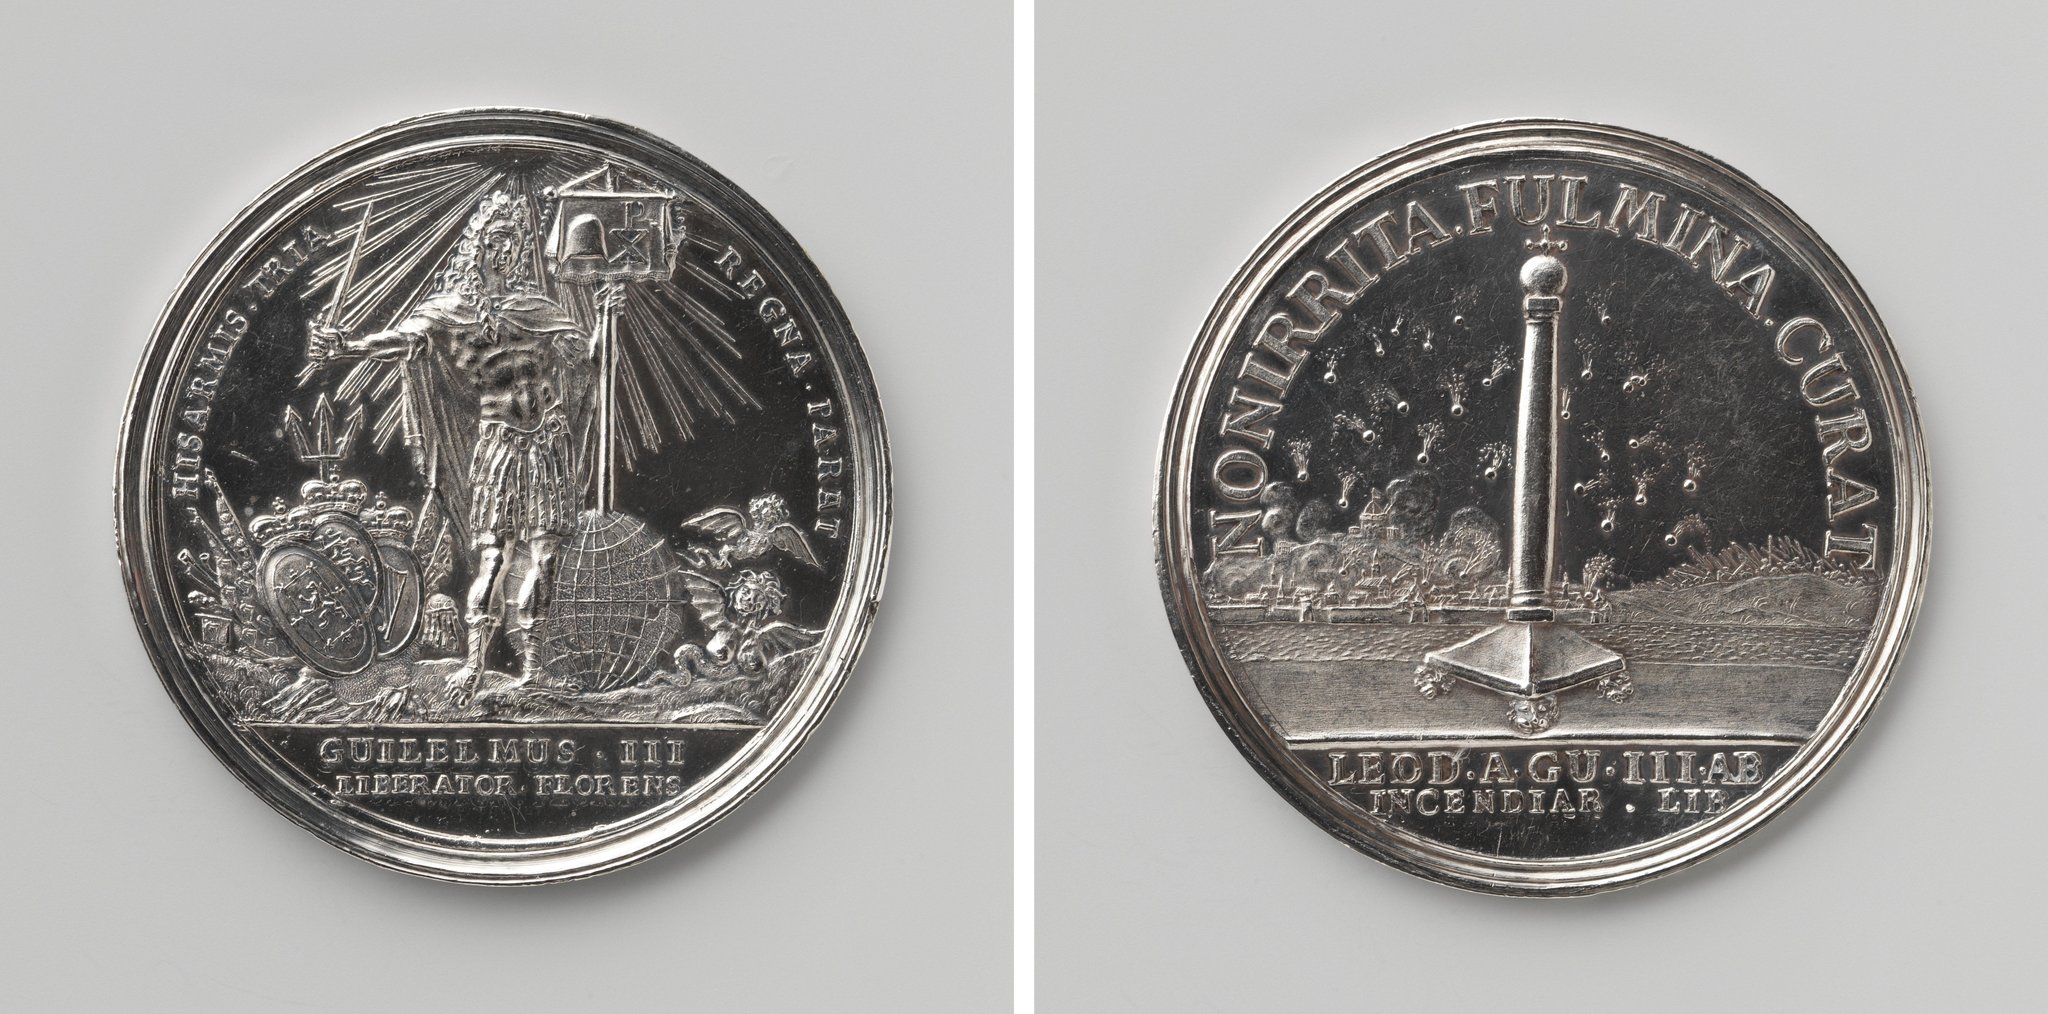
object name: history medal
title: Luik door Willem III bevrijd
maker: Anonymous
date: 1691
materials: silver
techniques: striking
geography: netherlands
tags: the hague, william iii (prince of orange and king of england, scotland, and ireland), liège